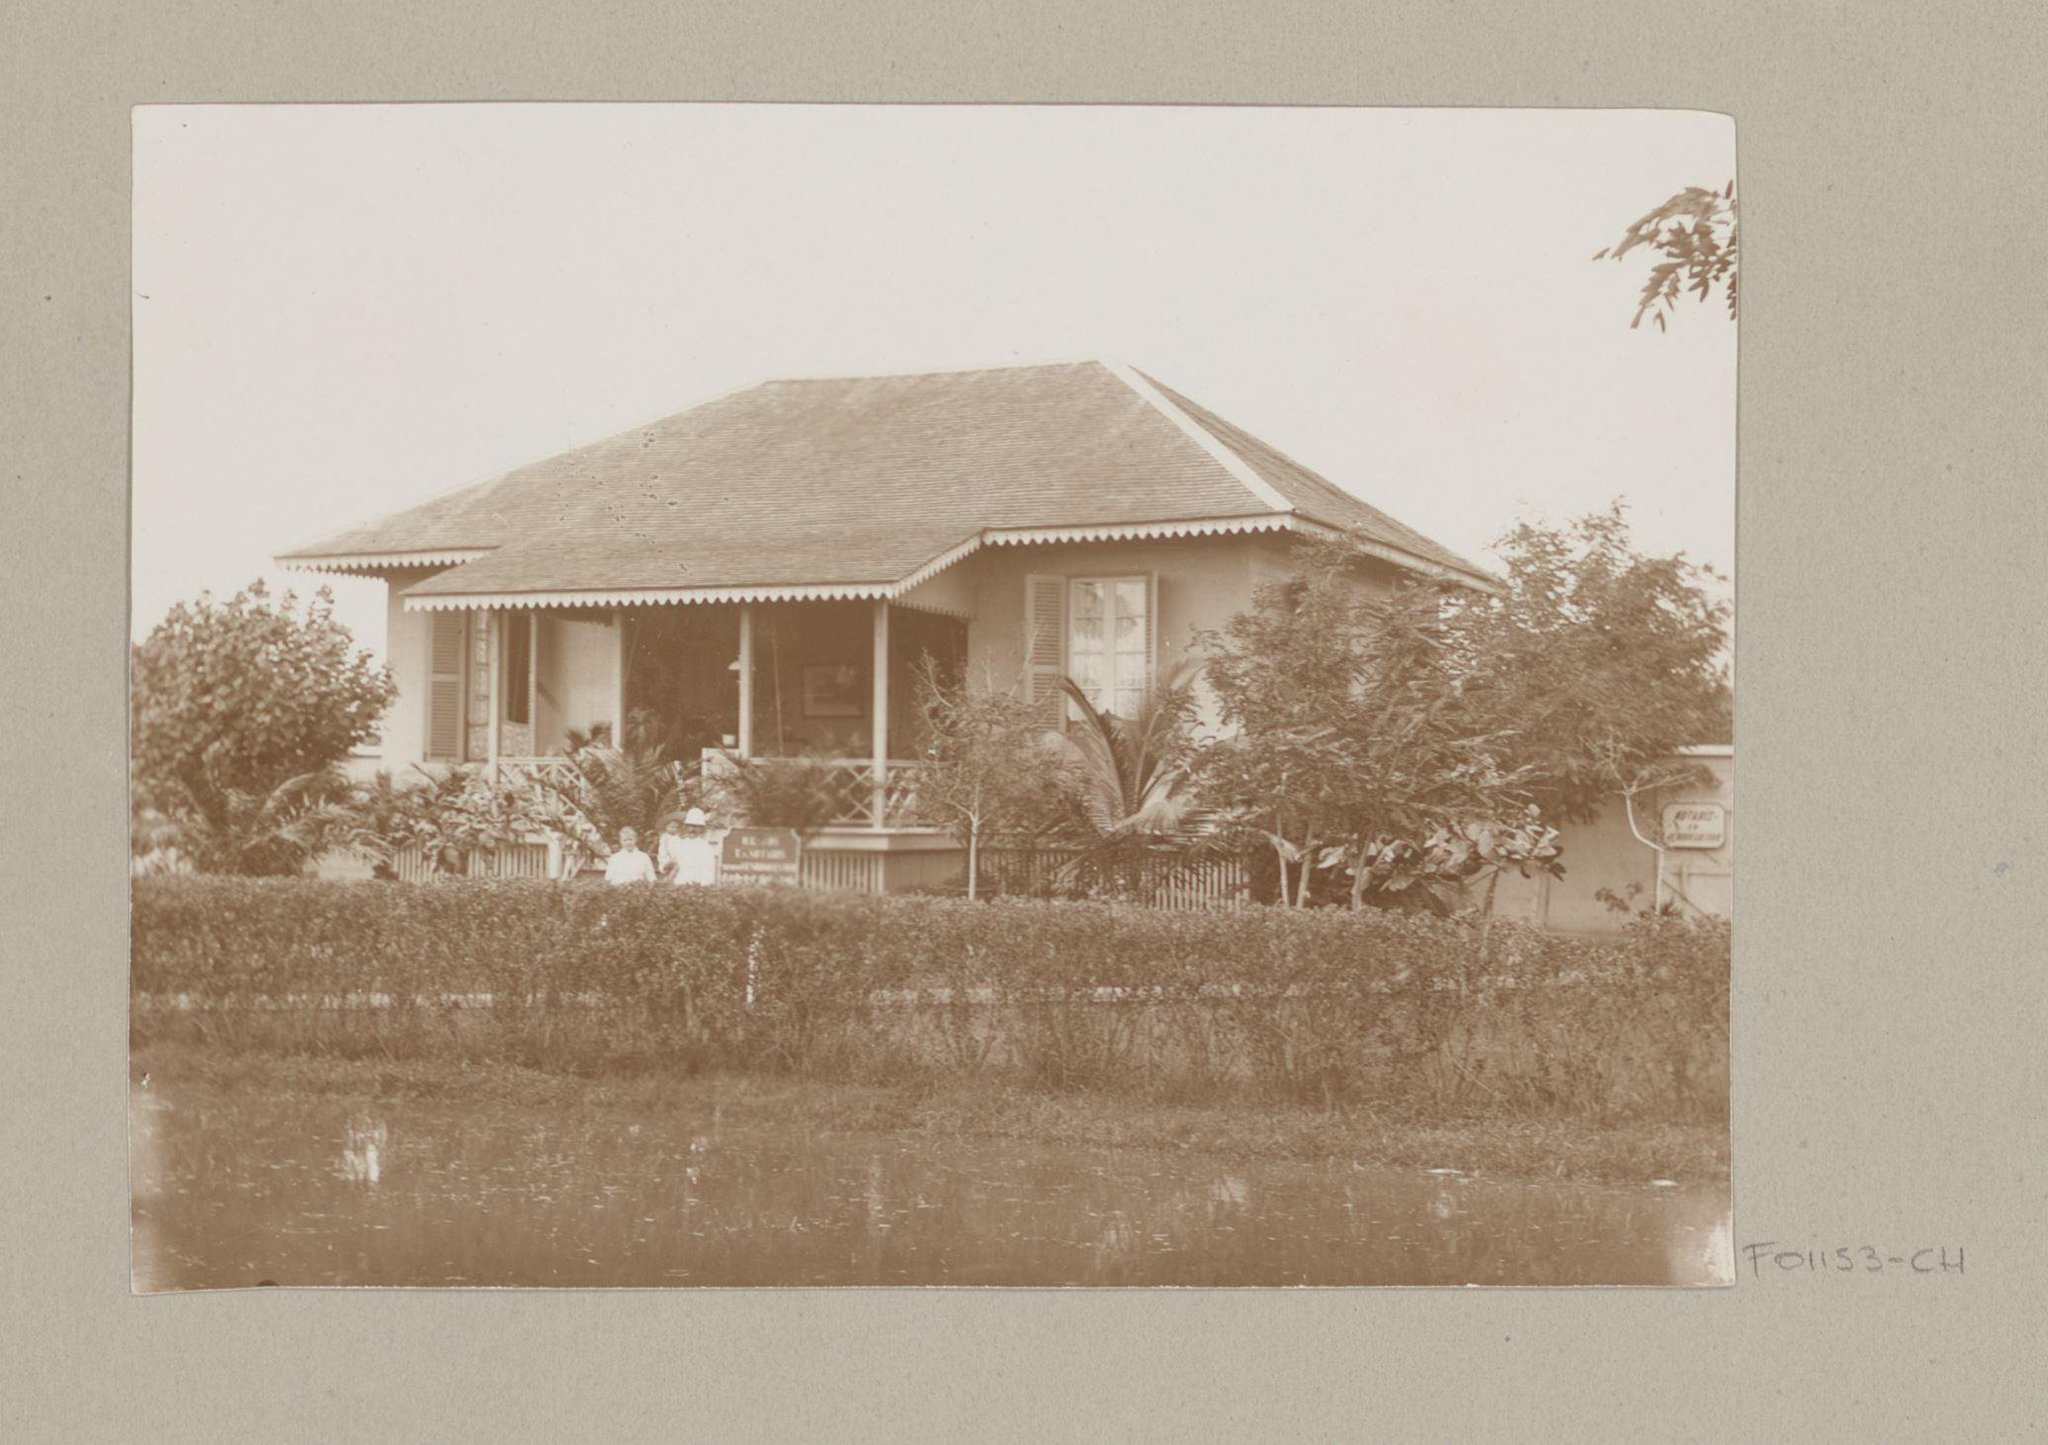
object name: photograph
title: Militair met gezin voor een huis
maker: Anonymous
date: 1890-1910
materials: photographic support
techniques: collodion silver print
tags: the soldier; the soldier's life, civic architecture; edifices; dwellings, dutch east indies, the